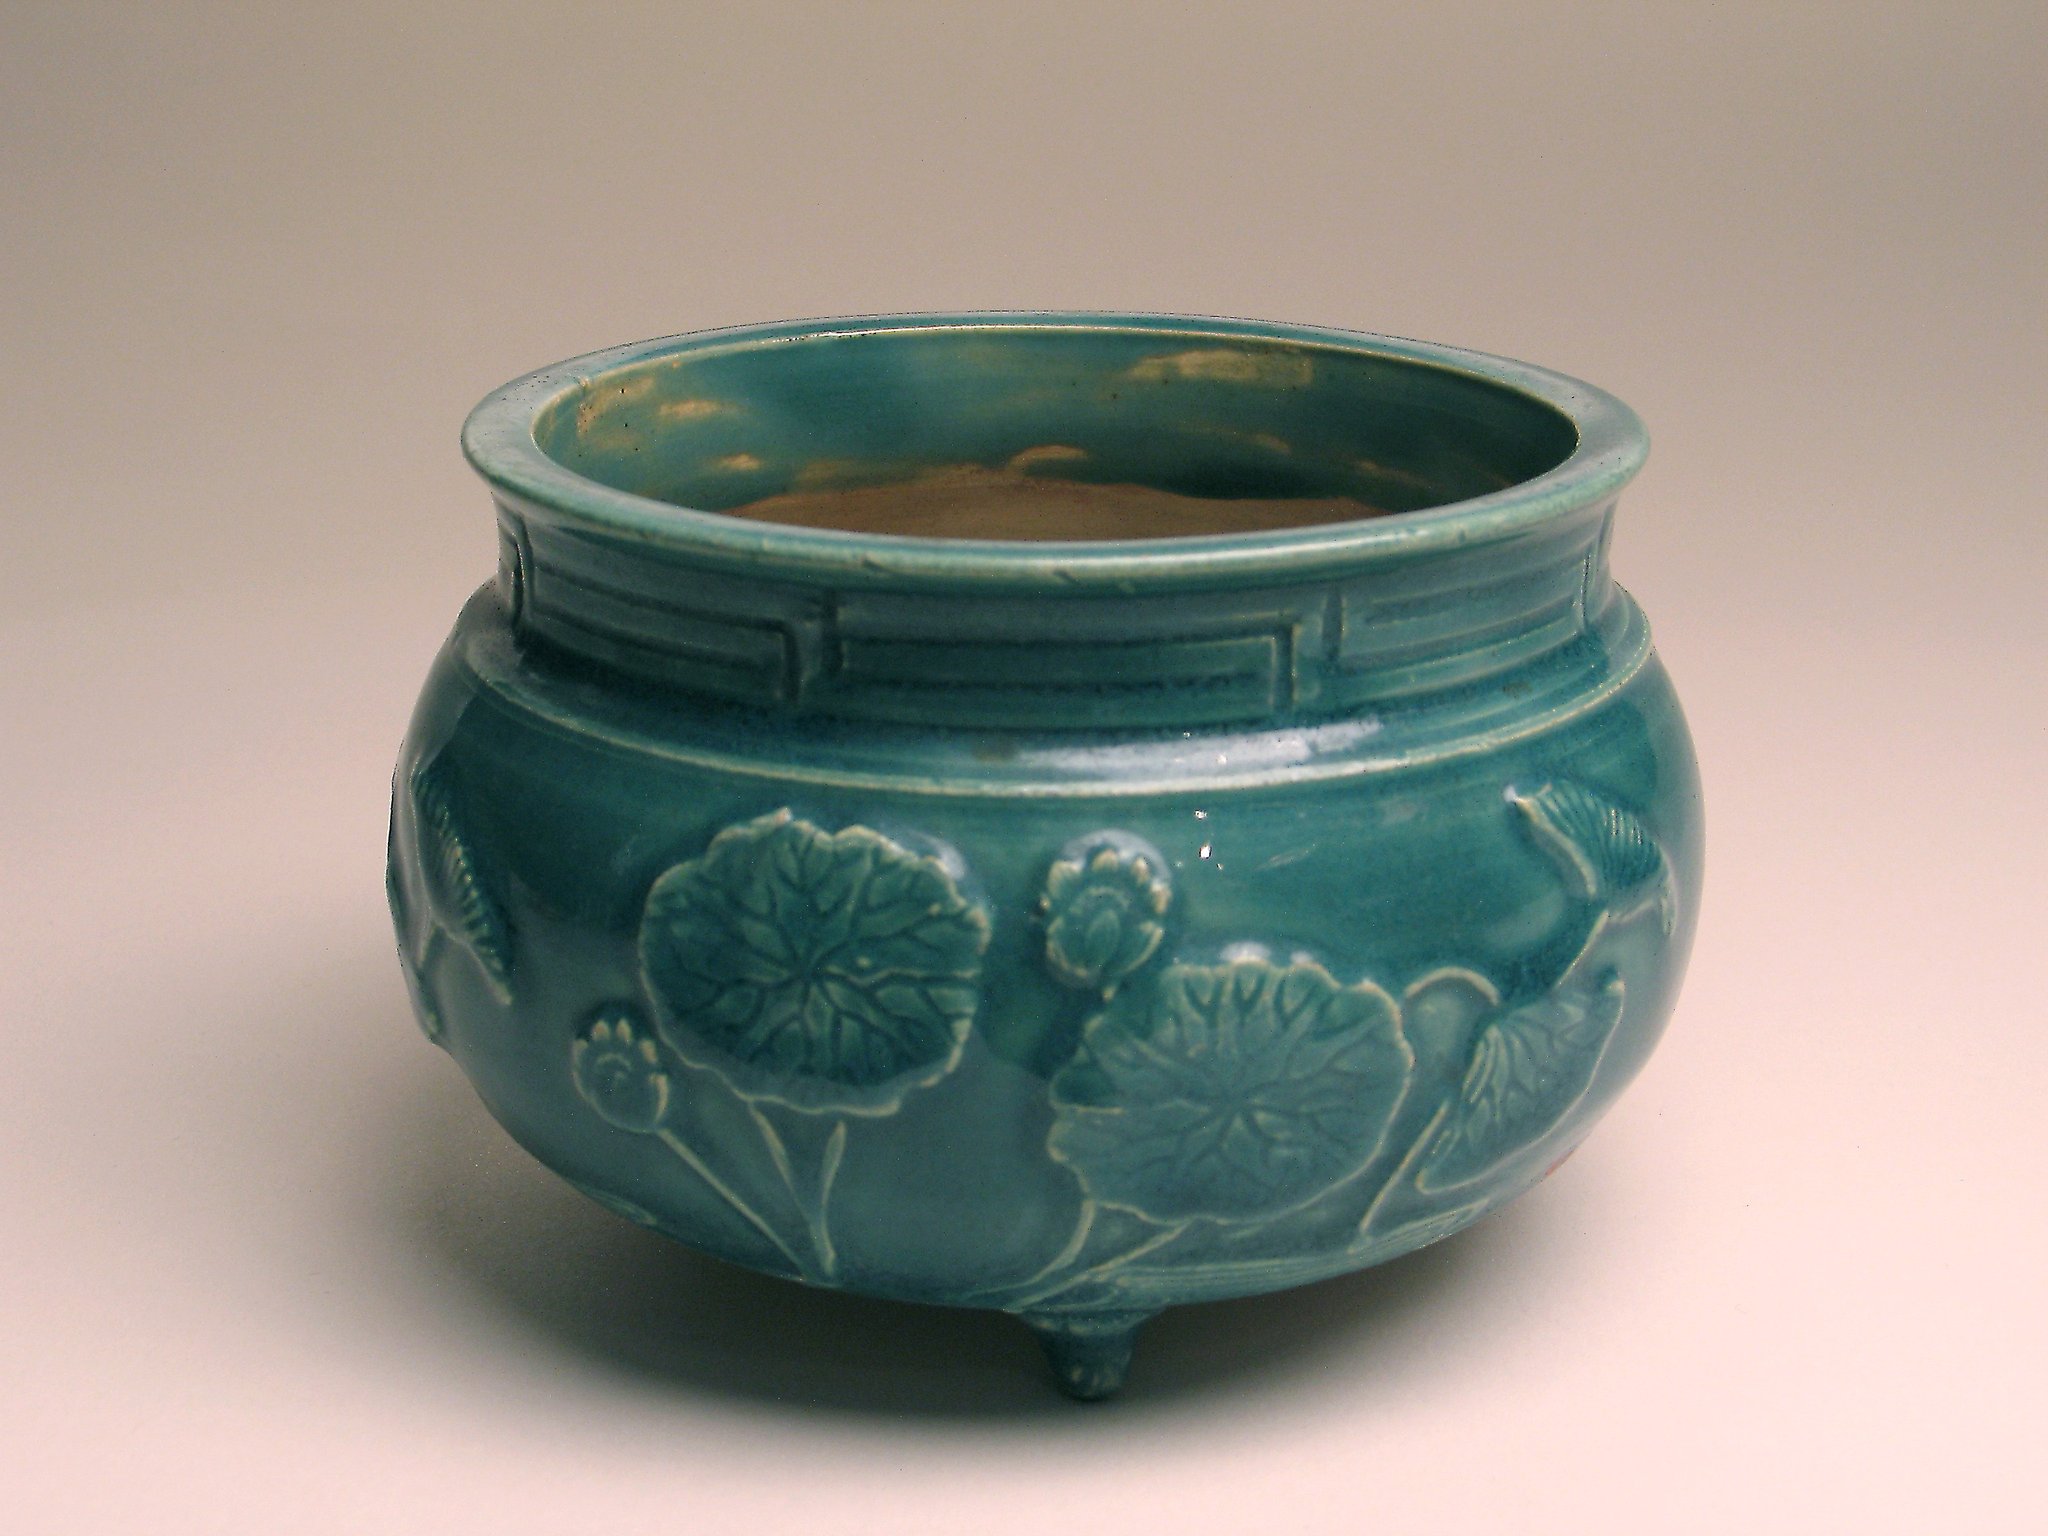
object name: censer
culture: japanese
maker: hozan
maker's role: artist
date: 1800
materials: clay, glaze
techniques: relief